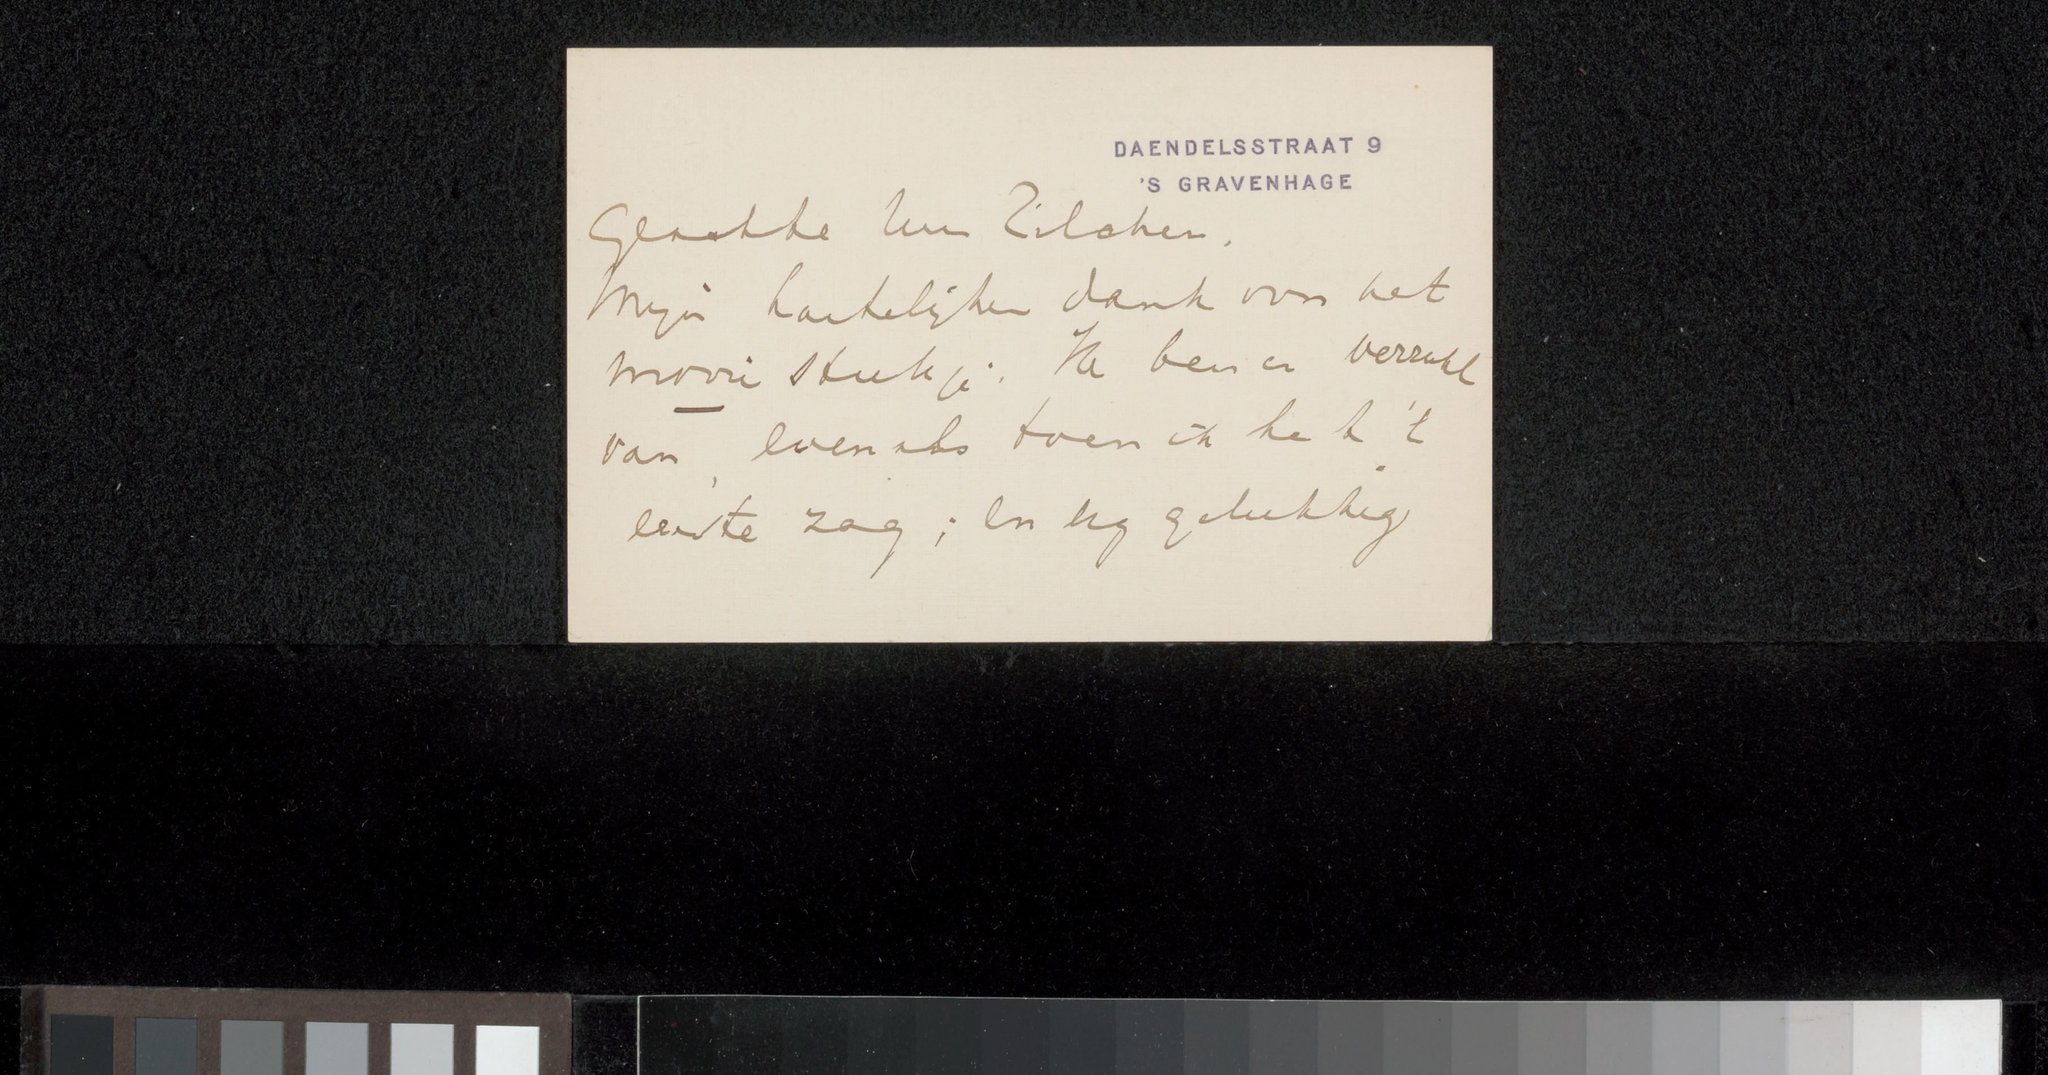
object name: letter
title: Brief aan Philip Zilcken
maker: elisabeth carolina van dorp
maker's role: politician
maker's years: 1872-1945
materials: cardboard, ink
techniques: pen, printing, writing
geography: the hague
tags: painter, draughtsman, philip zilcken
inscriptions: collector's mark: ‘RPK’, address: ‘DAENDELSSTRAAT 9/ 'S GRAVENHAGE’